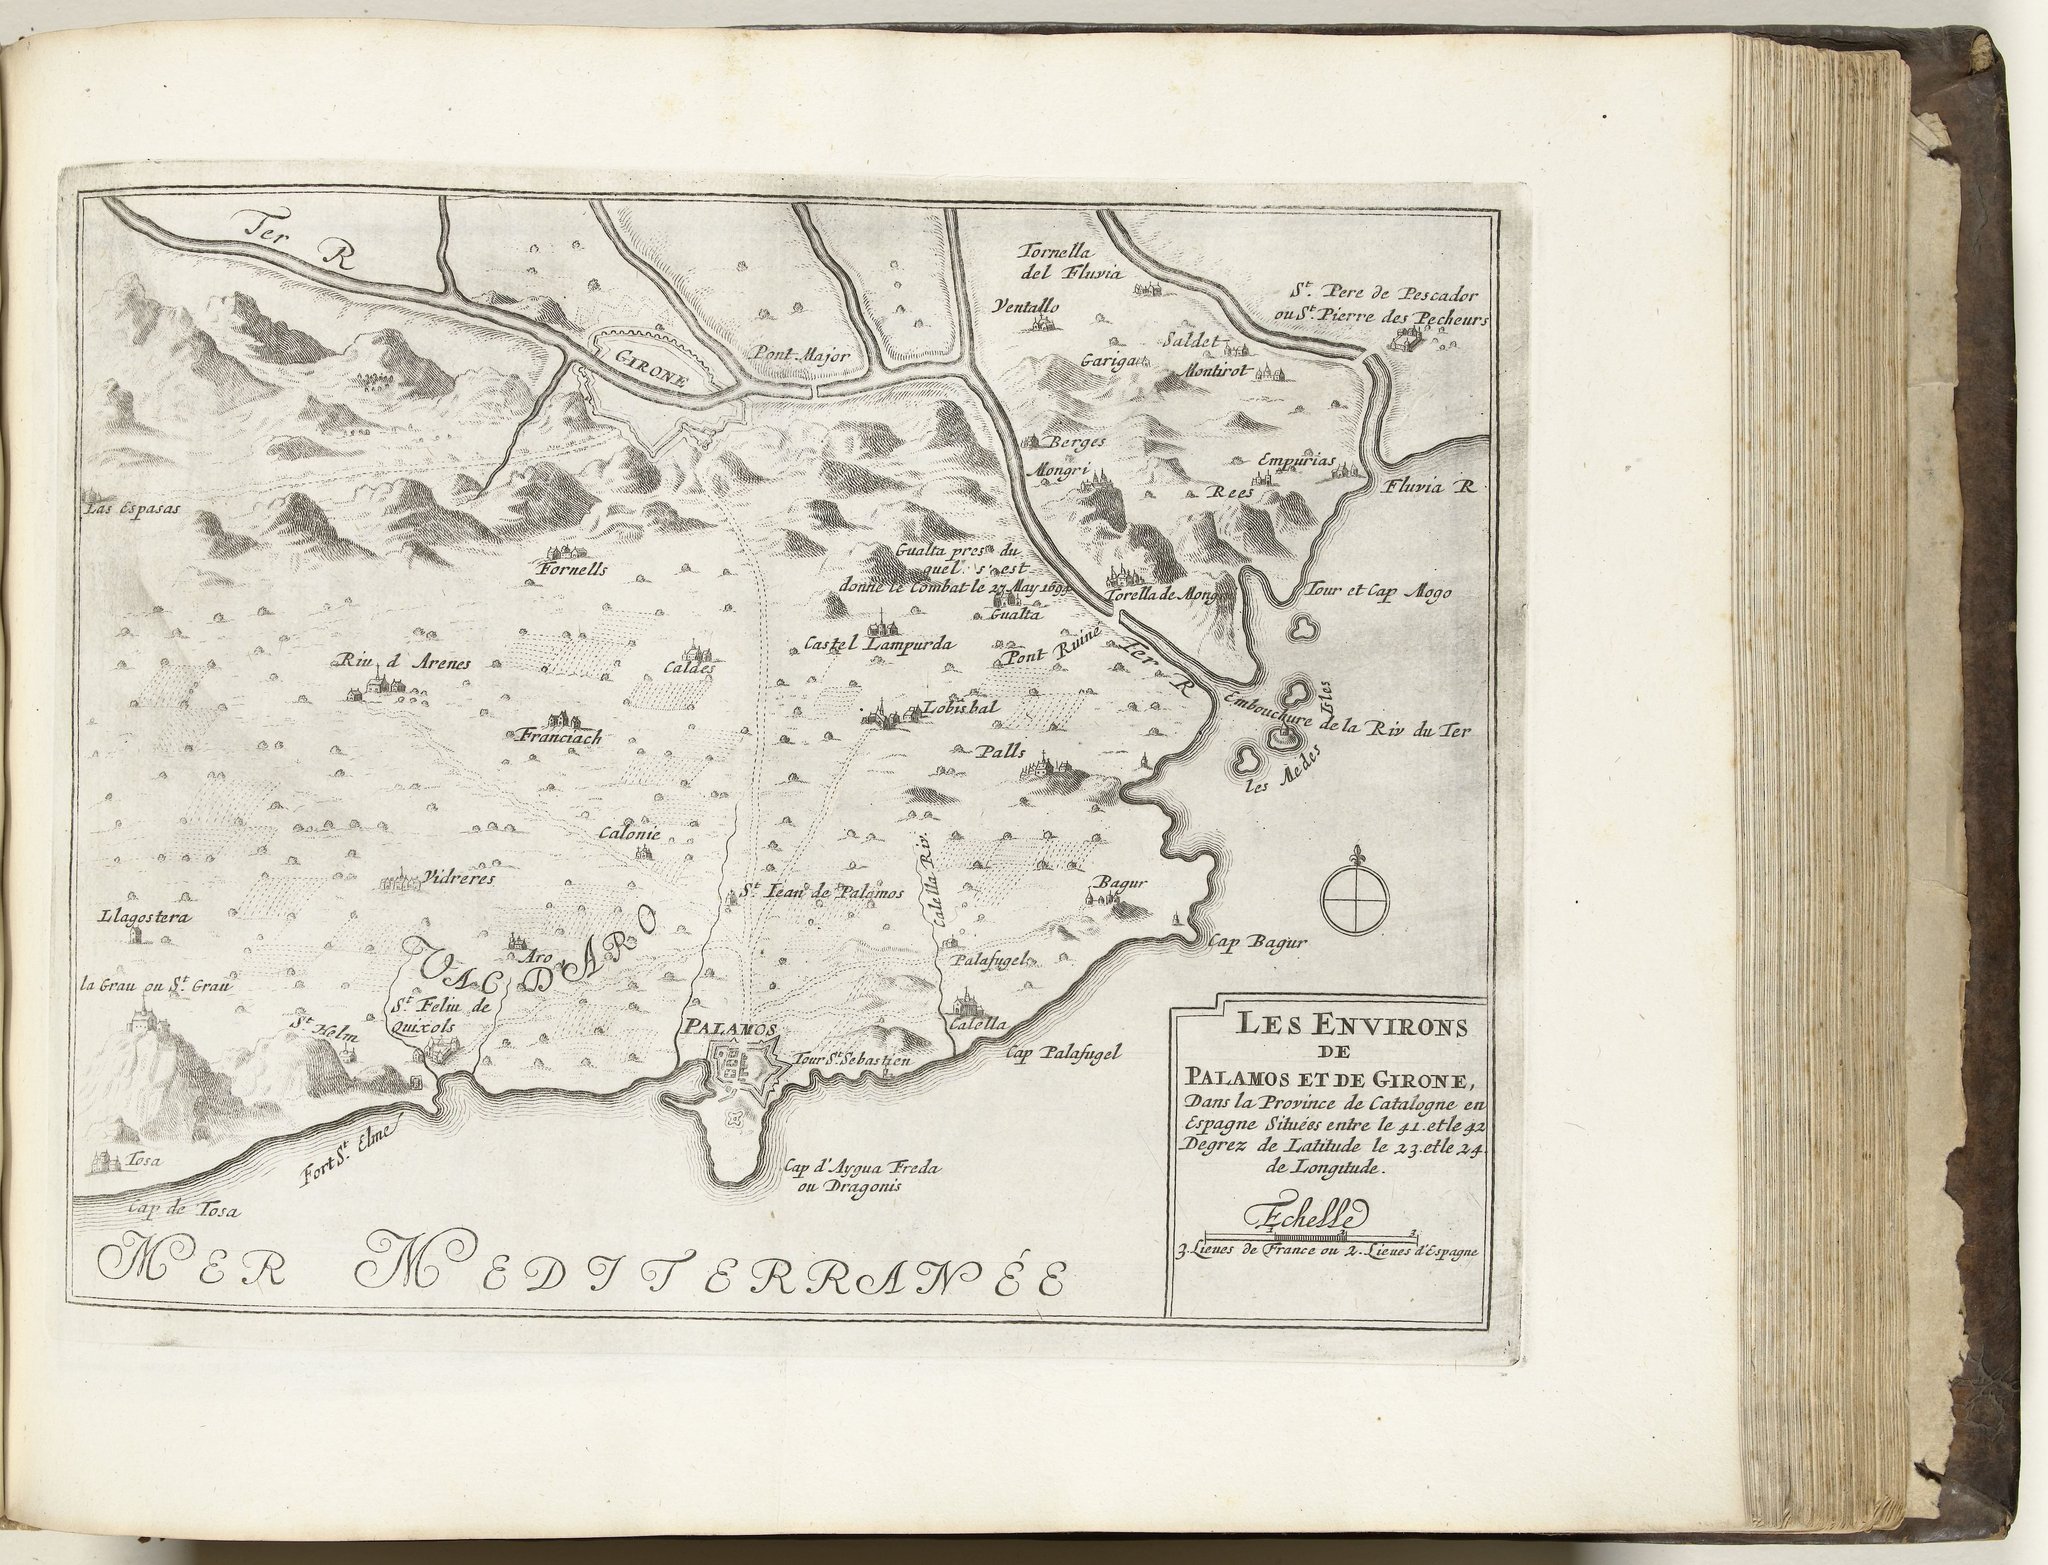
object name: print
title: Les Environs de Palamos et de Girone, Dans la Province de Catalogne en Espagne (...)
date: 1694-1696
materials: paper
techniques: etching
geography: france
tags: maps of separate countries or regions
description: Kaart van de Spaanse kust in de omgeving van Palamos en Gerona. Onderdeel van het zevende deel (1696) van het prentwerk waarin gebundeld zijn de acht delen van Les forces de l'Europe uitgegeven tussen 1693-1697. Het prentwerk bestaat uit 175 platen met plannen (afkomstig van Sébastien Le Prestre, Seigneur de Vauban) van vermaarde sterke steden en vestingen in de Negenjarige Oorlog. Titel en opschriften in het Frans.